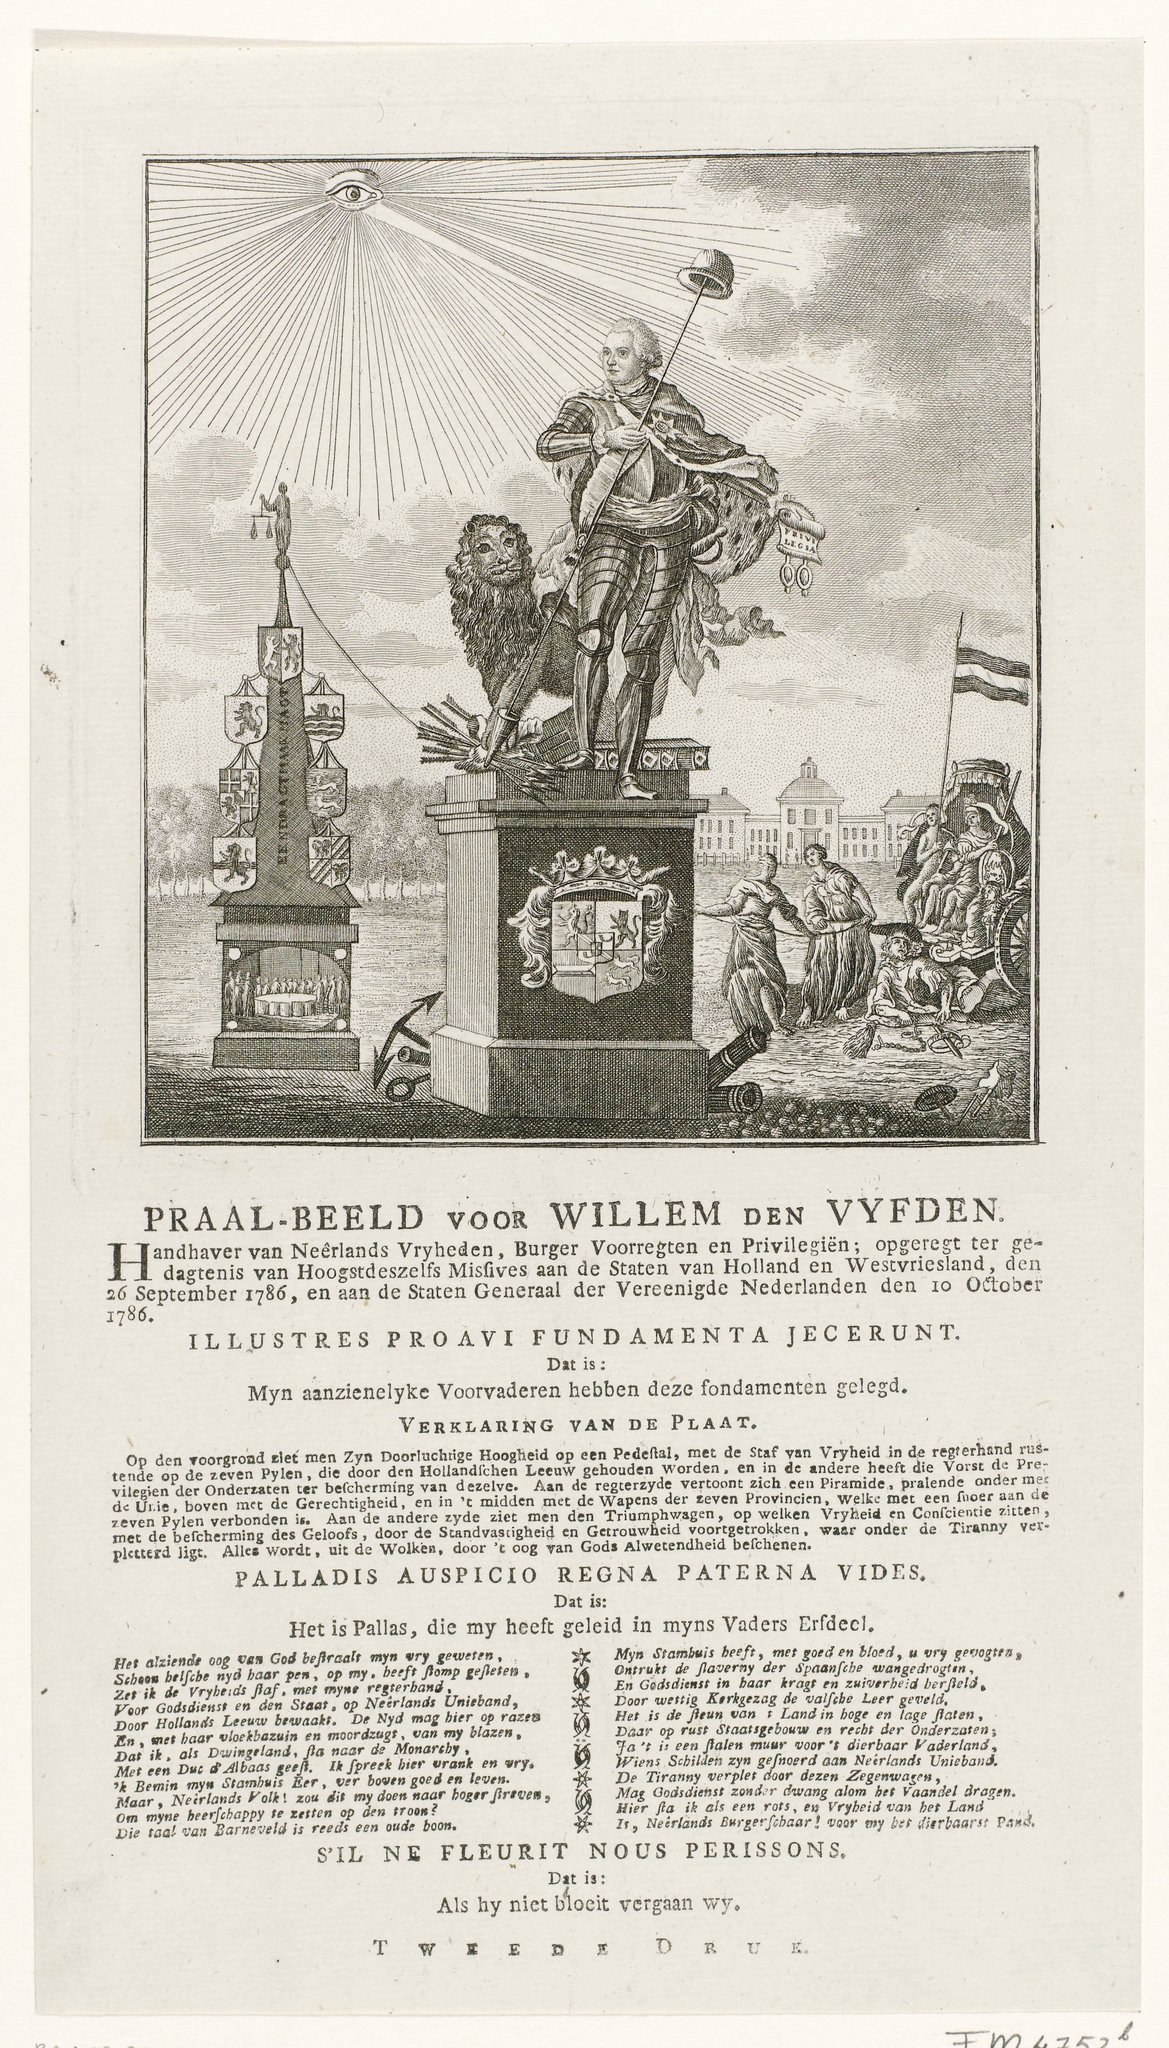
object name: print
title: Praal-Beeld voor Willem den Vyfden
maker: Anonymous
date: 1787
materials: paper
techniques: engraving, etching, letterpress printing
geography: northern netherlands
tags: william v (prince of orange), monument, statue, the all-seeing eye, triangle with eye ~ symbol of god the father, homage to a ruler, patriots (1780-1795)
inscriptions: collector's mark: Lugt 2228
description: Allegrorisch standbeeld ter ere van van stadhouder Willem V, naar aanleiding van zijn missieven aan de Staten van Holland en West-Friesland van 26 september 1786 en aan de Staten-Generaal van 10 oktober 1786 (Tweede druk). Beeld van de prins in wapenrusting met speer en vrijheidshoed en privileges van het volk, achter hem de Nederlandse Leeuw. Links een monument van de Rechtvaardigheid met de wapens van de zeven provincies, rechts een triomfwagen van de Vrijheid die de Tirannie onder haar wielen verplettert. In de hemel het Alziende Oog. Op de achtergrond Paleis Het Loo. Op het blad onder de plaat een verklaring van de voorstelling en een vers in twee kolommen. Bij de plaat behoort een pendant.